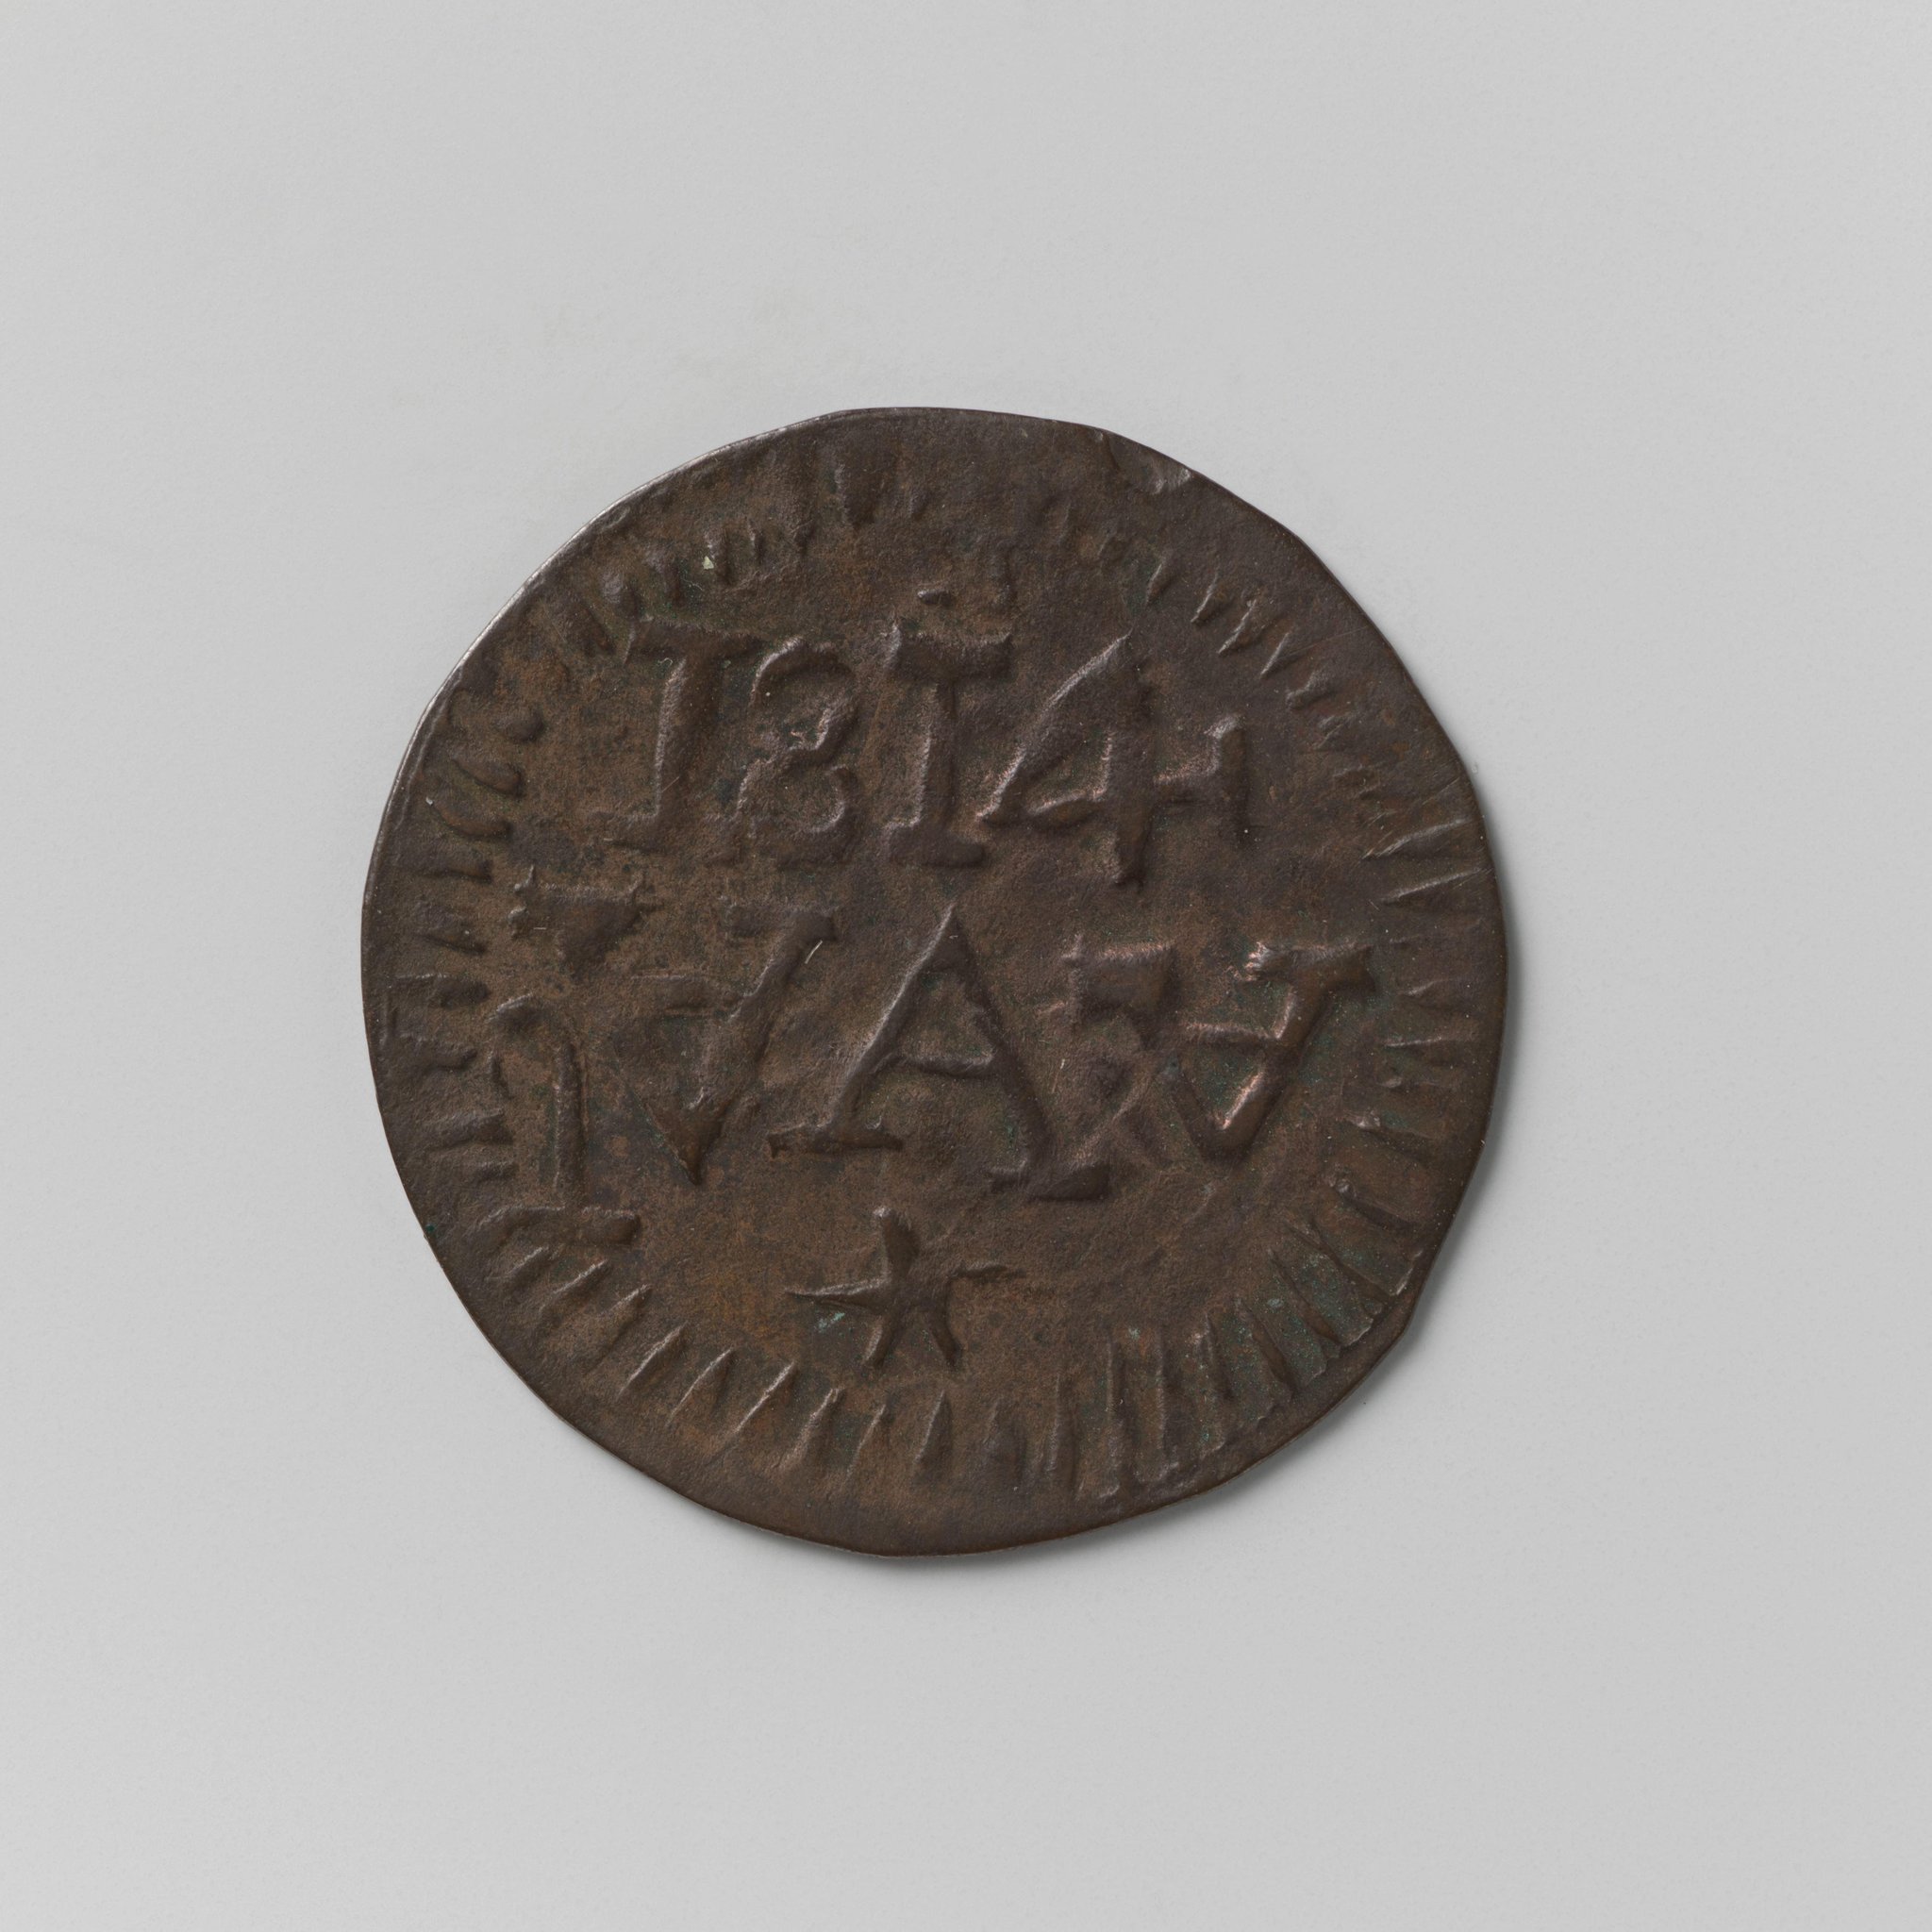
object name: coin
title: Nederlands Indië tijdens Brits bestuur, 1/2 stuiver Java, 1814, ruwe nabootsing uit Zuid-Borneo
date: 1814-1820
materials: copper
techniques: striking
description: Koperen munt. Voorzijde: imitatie van: tussen waarde-aanduiding 1/2 St monogram van de Engelse Oostindische Compagnie. Daarboven letter b. Keerzijde: eenregelig opschrift, waaronder jaartal. Boven opschrift geïmiteerd muntteken en onder jaartal geïmiteerd muntmeesterteken.